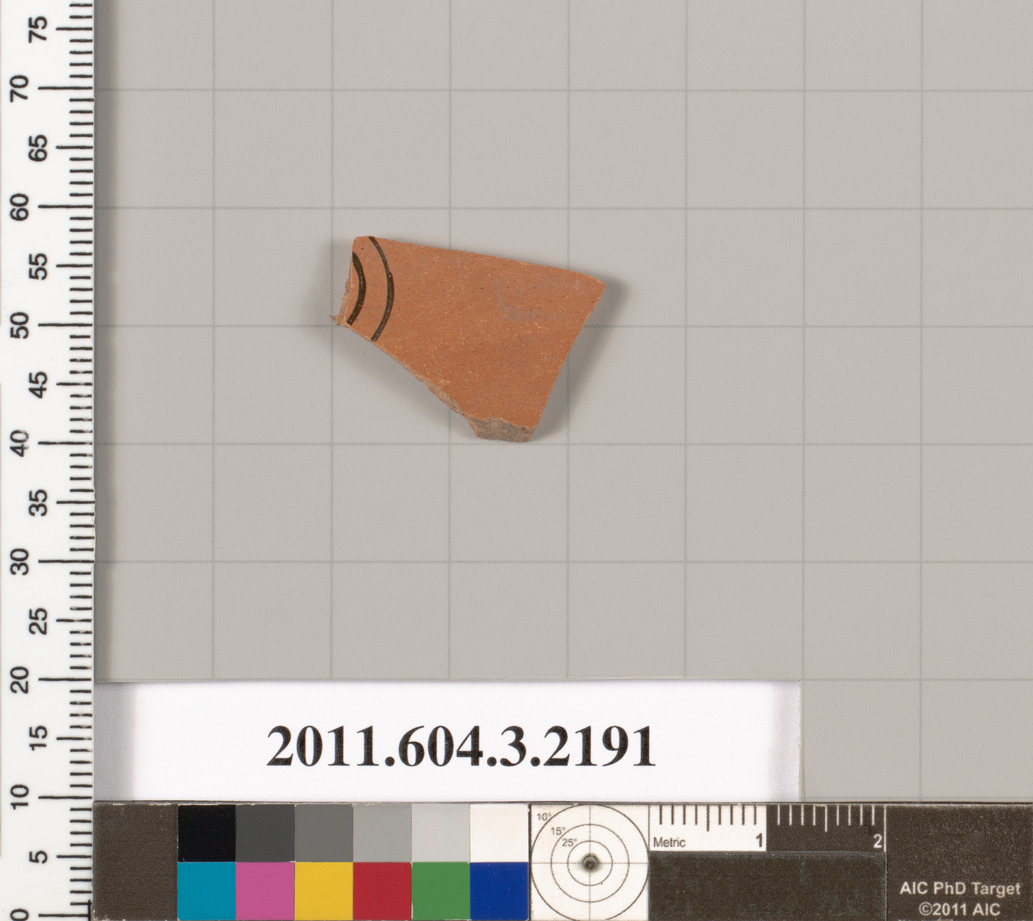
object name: kylix fragment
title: Terracotta fragment of a kylix (drinking cup)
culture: greek, attic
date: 525-501 BCE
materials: terracotta